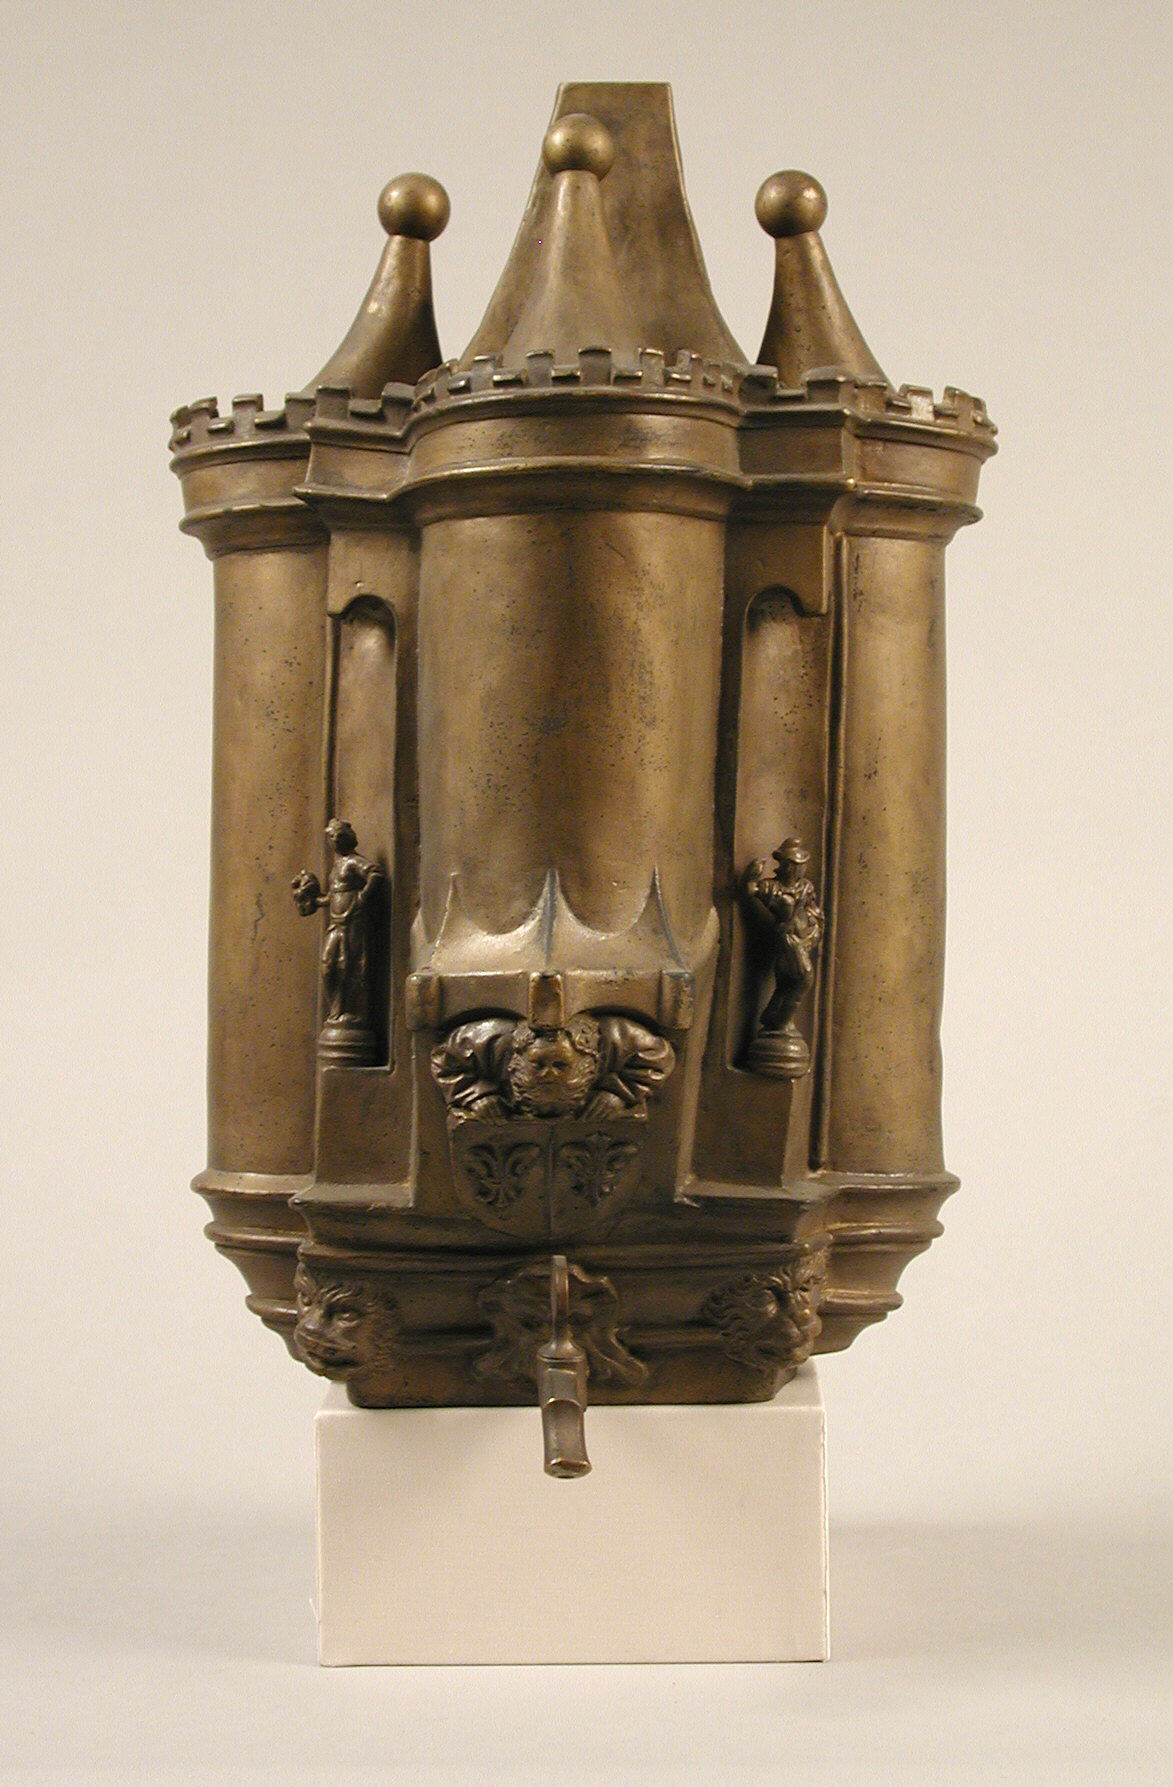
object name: cistern or fountain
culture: german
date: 1901-1933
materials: brass, bronze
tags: human figures